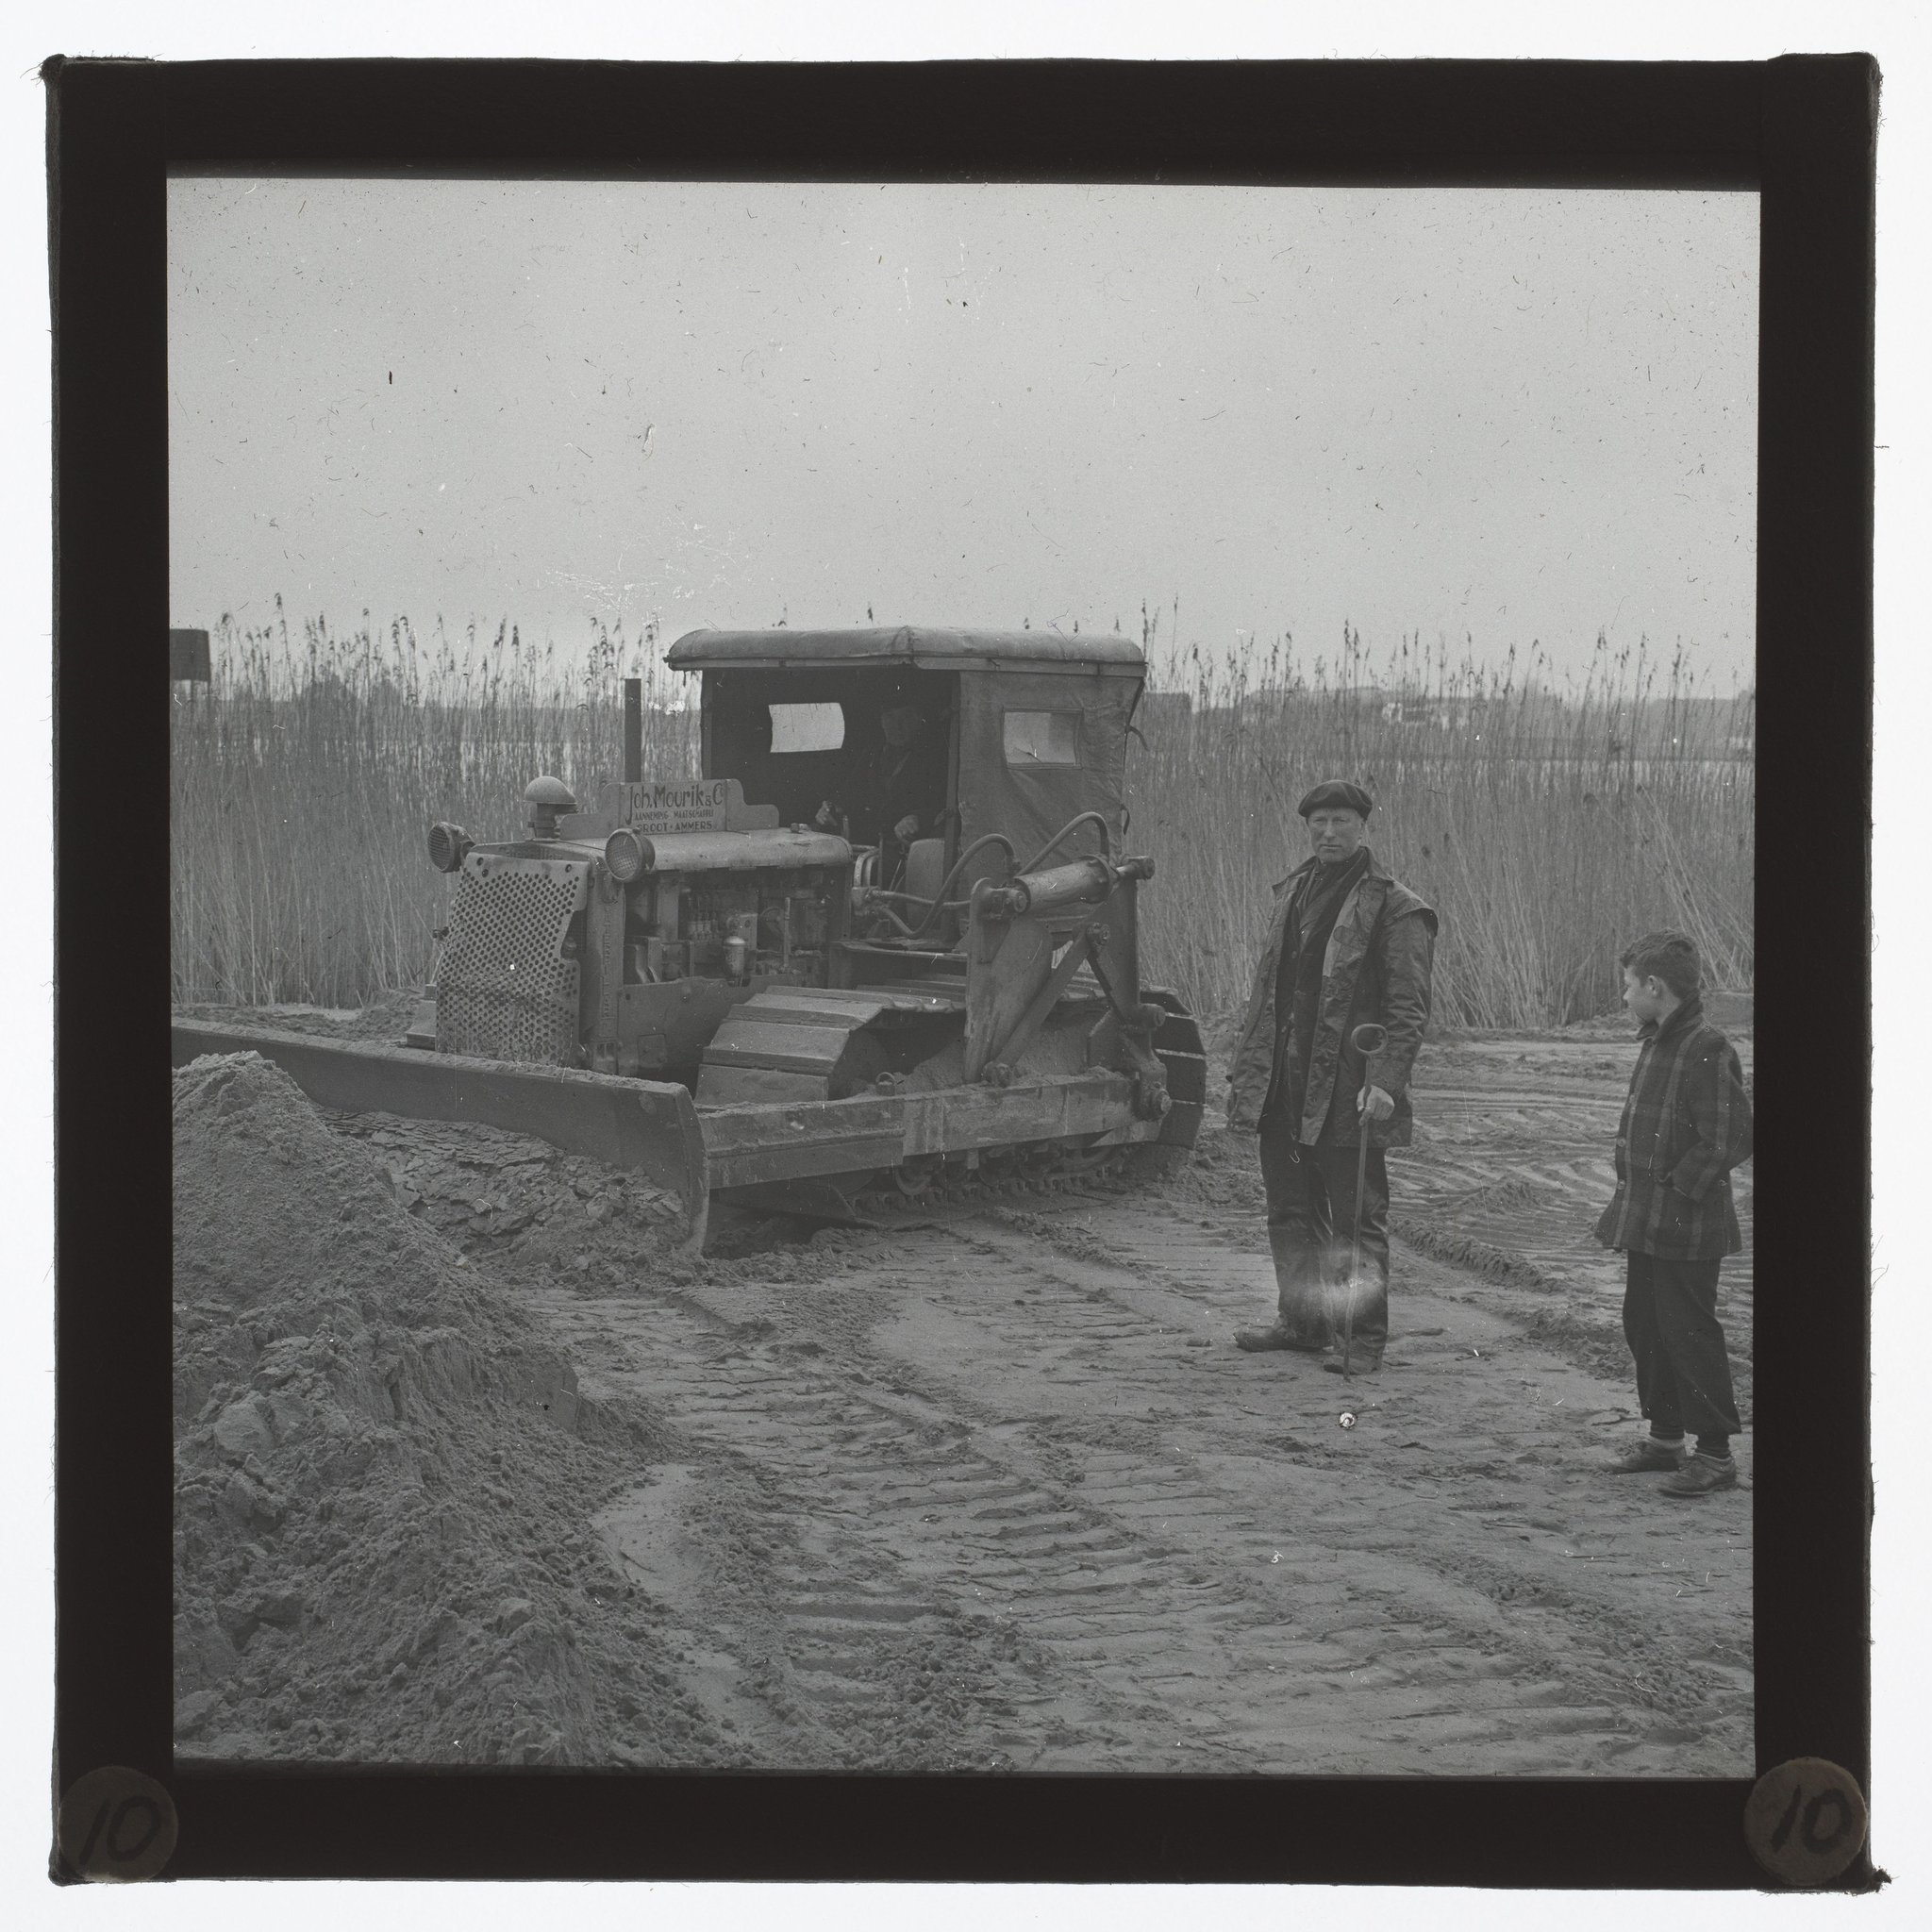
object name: lantern slide photographic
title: Mannen bij een bulldozer, Zuid-Holland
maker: Anonymous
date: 1956-1960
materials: glass, paper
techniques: gelatin silver transparency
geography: south holland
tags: earth moving techniques (~ building activities), public road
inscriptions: number: ‘10’